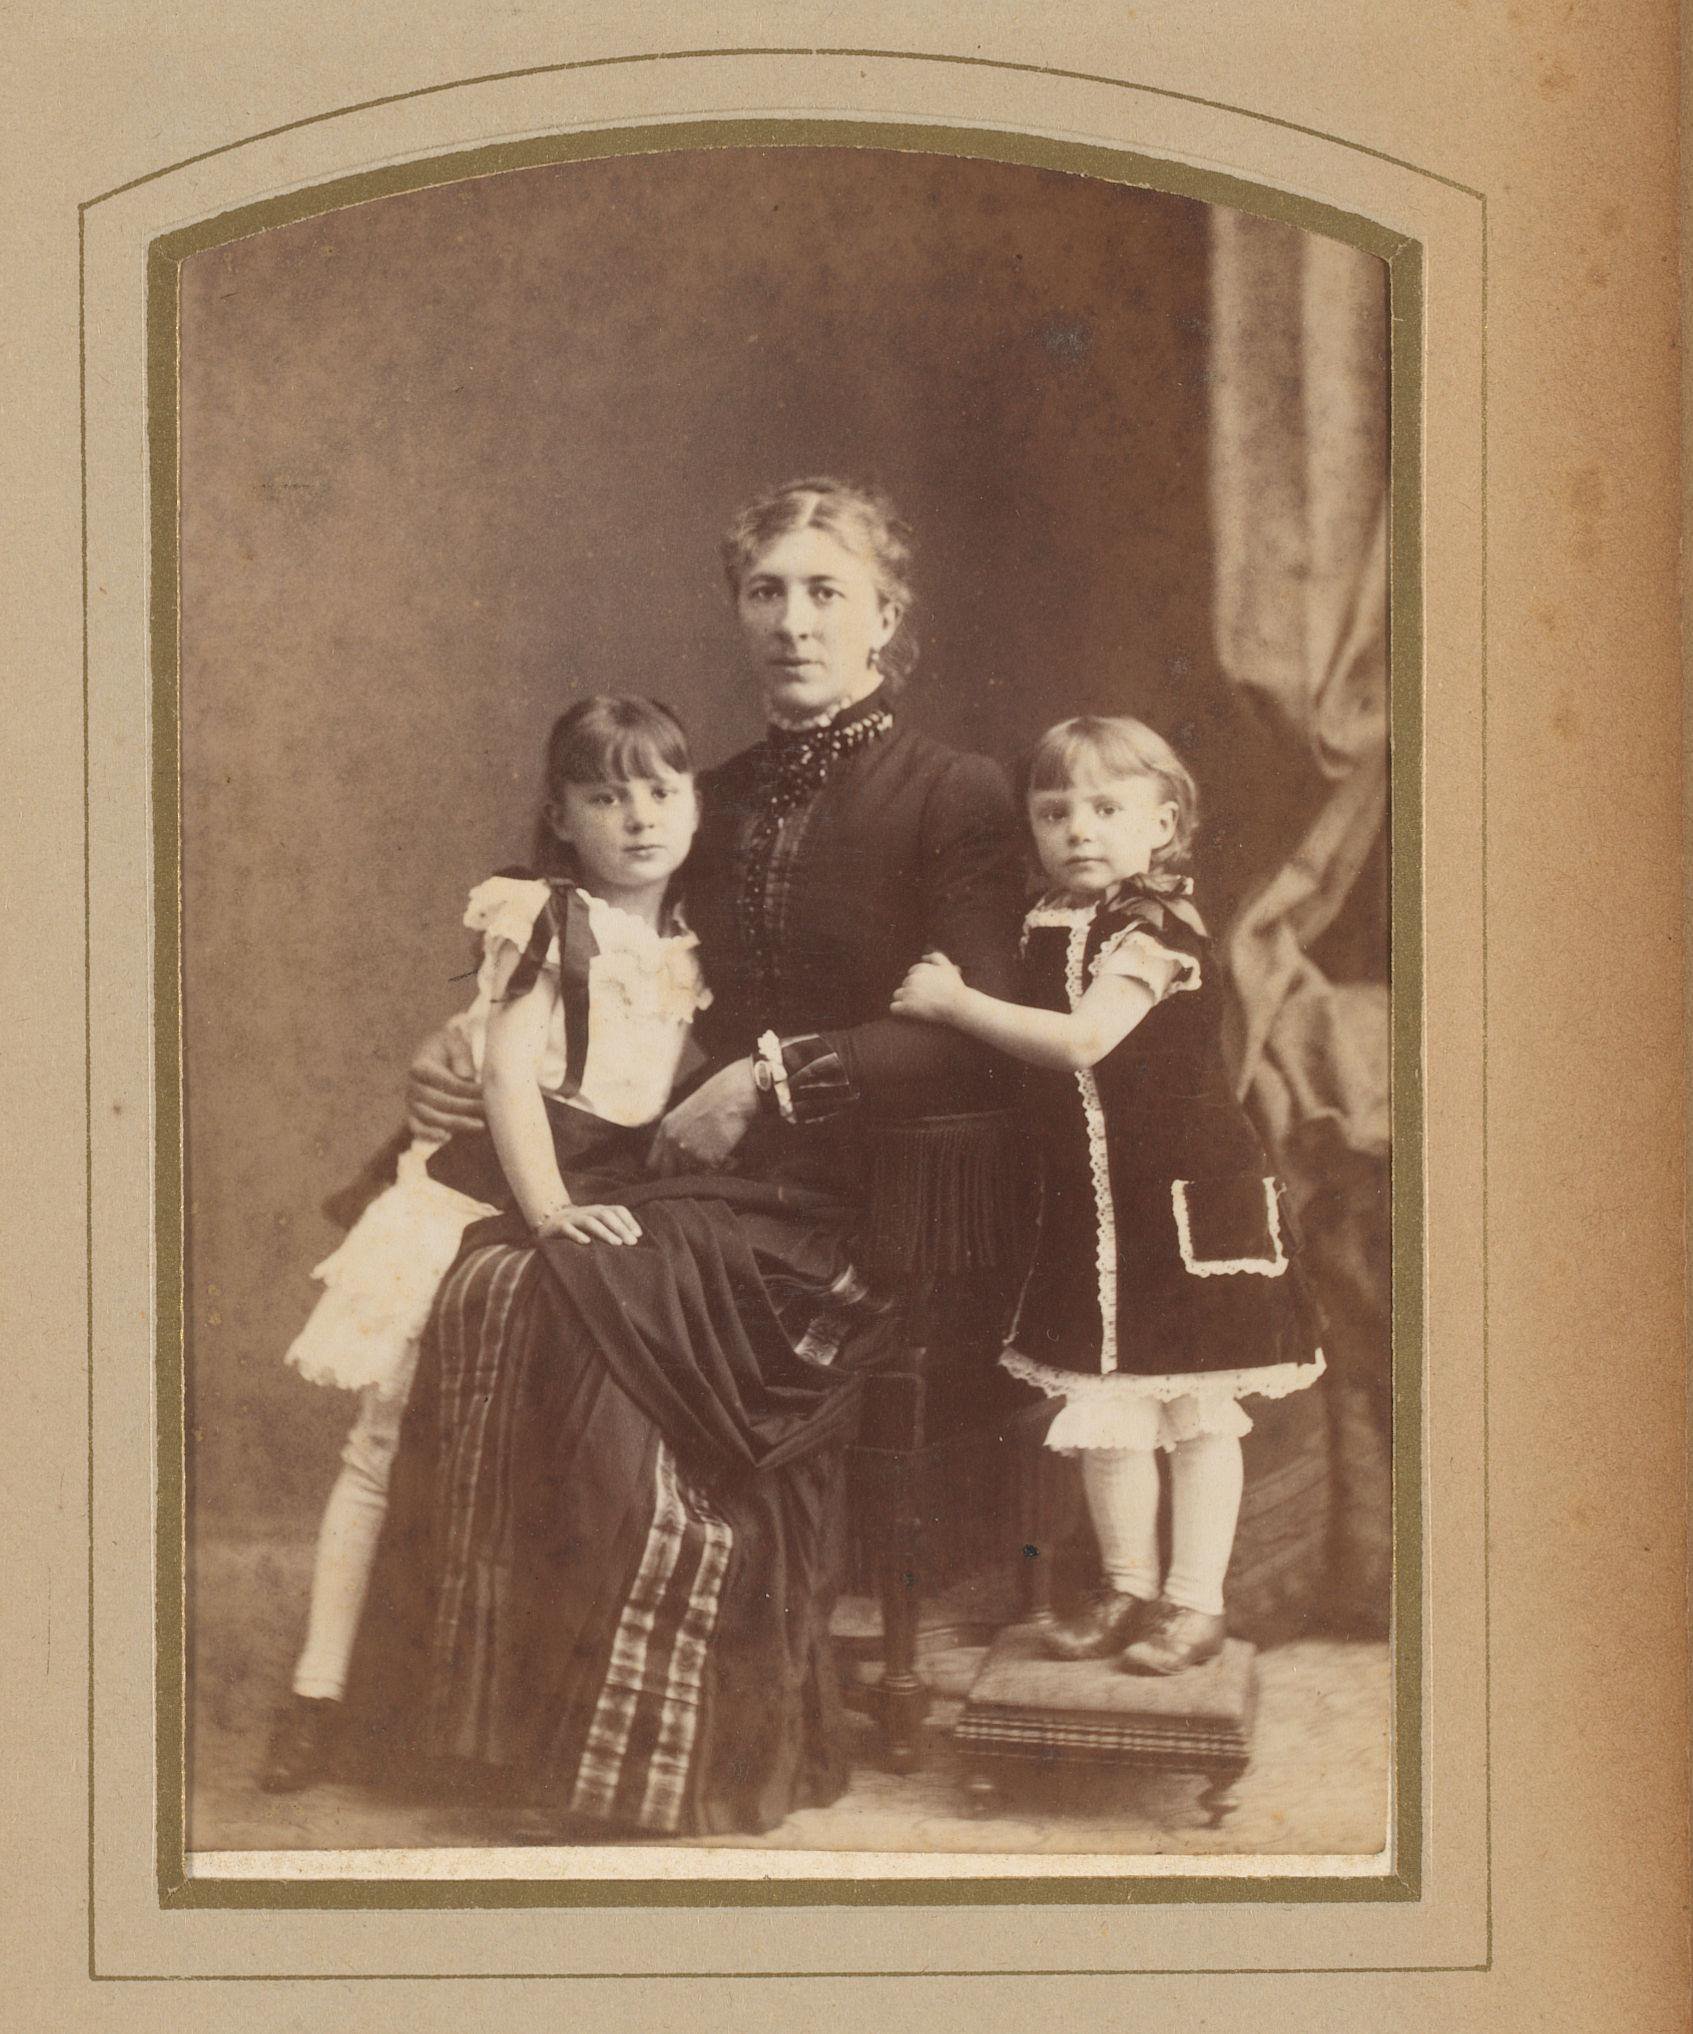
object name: photograph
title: Portret van Amelia Kruimel-Schmidt van Gelder en haar kinderen Ali[(...)] en Amy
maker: johannes petrus oppers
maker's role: fotograaf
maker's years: 1833-1890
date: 1869-1890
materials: cardboard, paper, photographic support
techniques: albumen print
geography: amsterdam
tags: studio requisites ~ photographer, historical persons - bb - woman, mother and child(ren), woman and child(ren) (family group), amsterdam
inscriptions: address: ‘Kalverstraat, 103 Amsterdam’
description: Onderdeel van Fotoalbum van de familie Boelen.